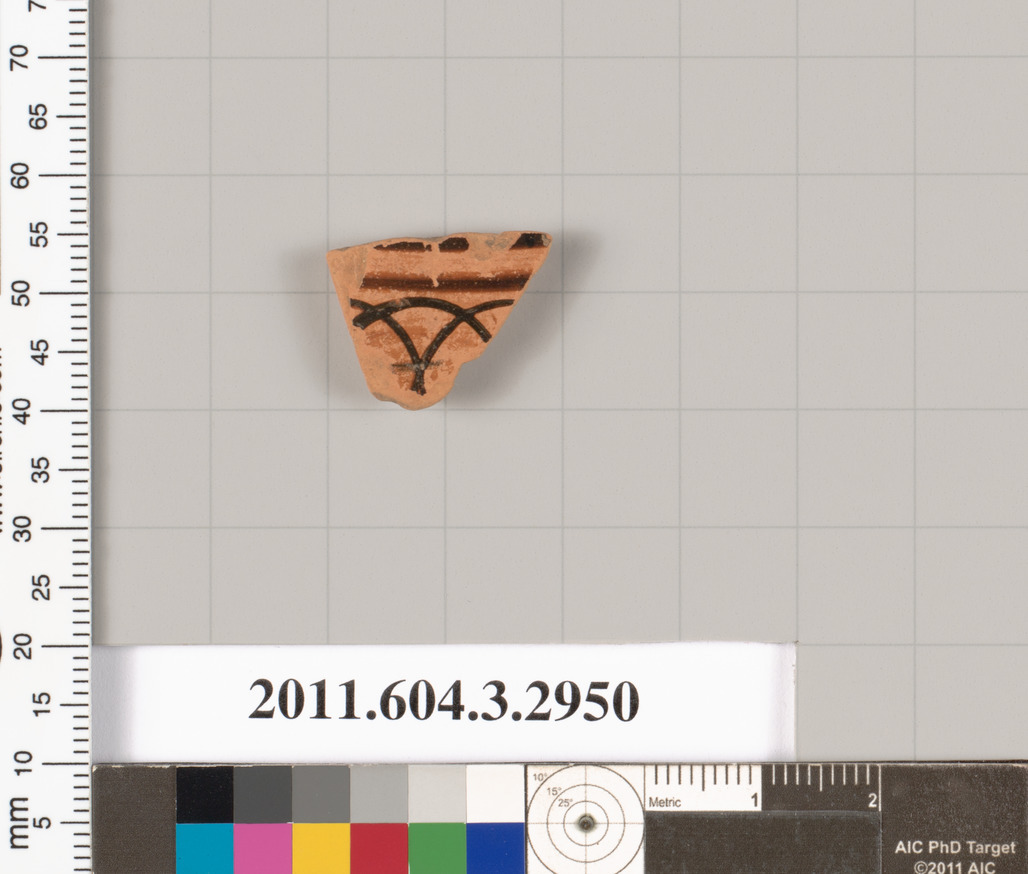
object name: undetermined closed shape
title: Terracotta fragment of a closed shape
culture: greek, attic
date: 600-401 BCE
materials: terracotta